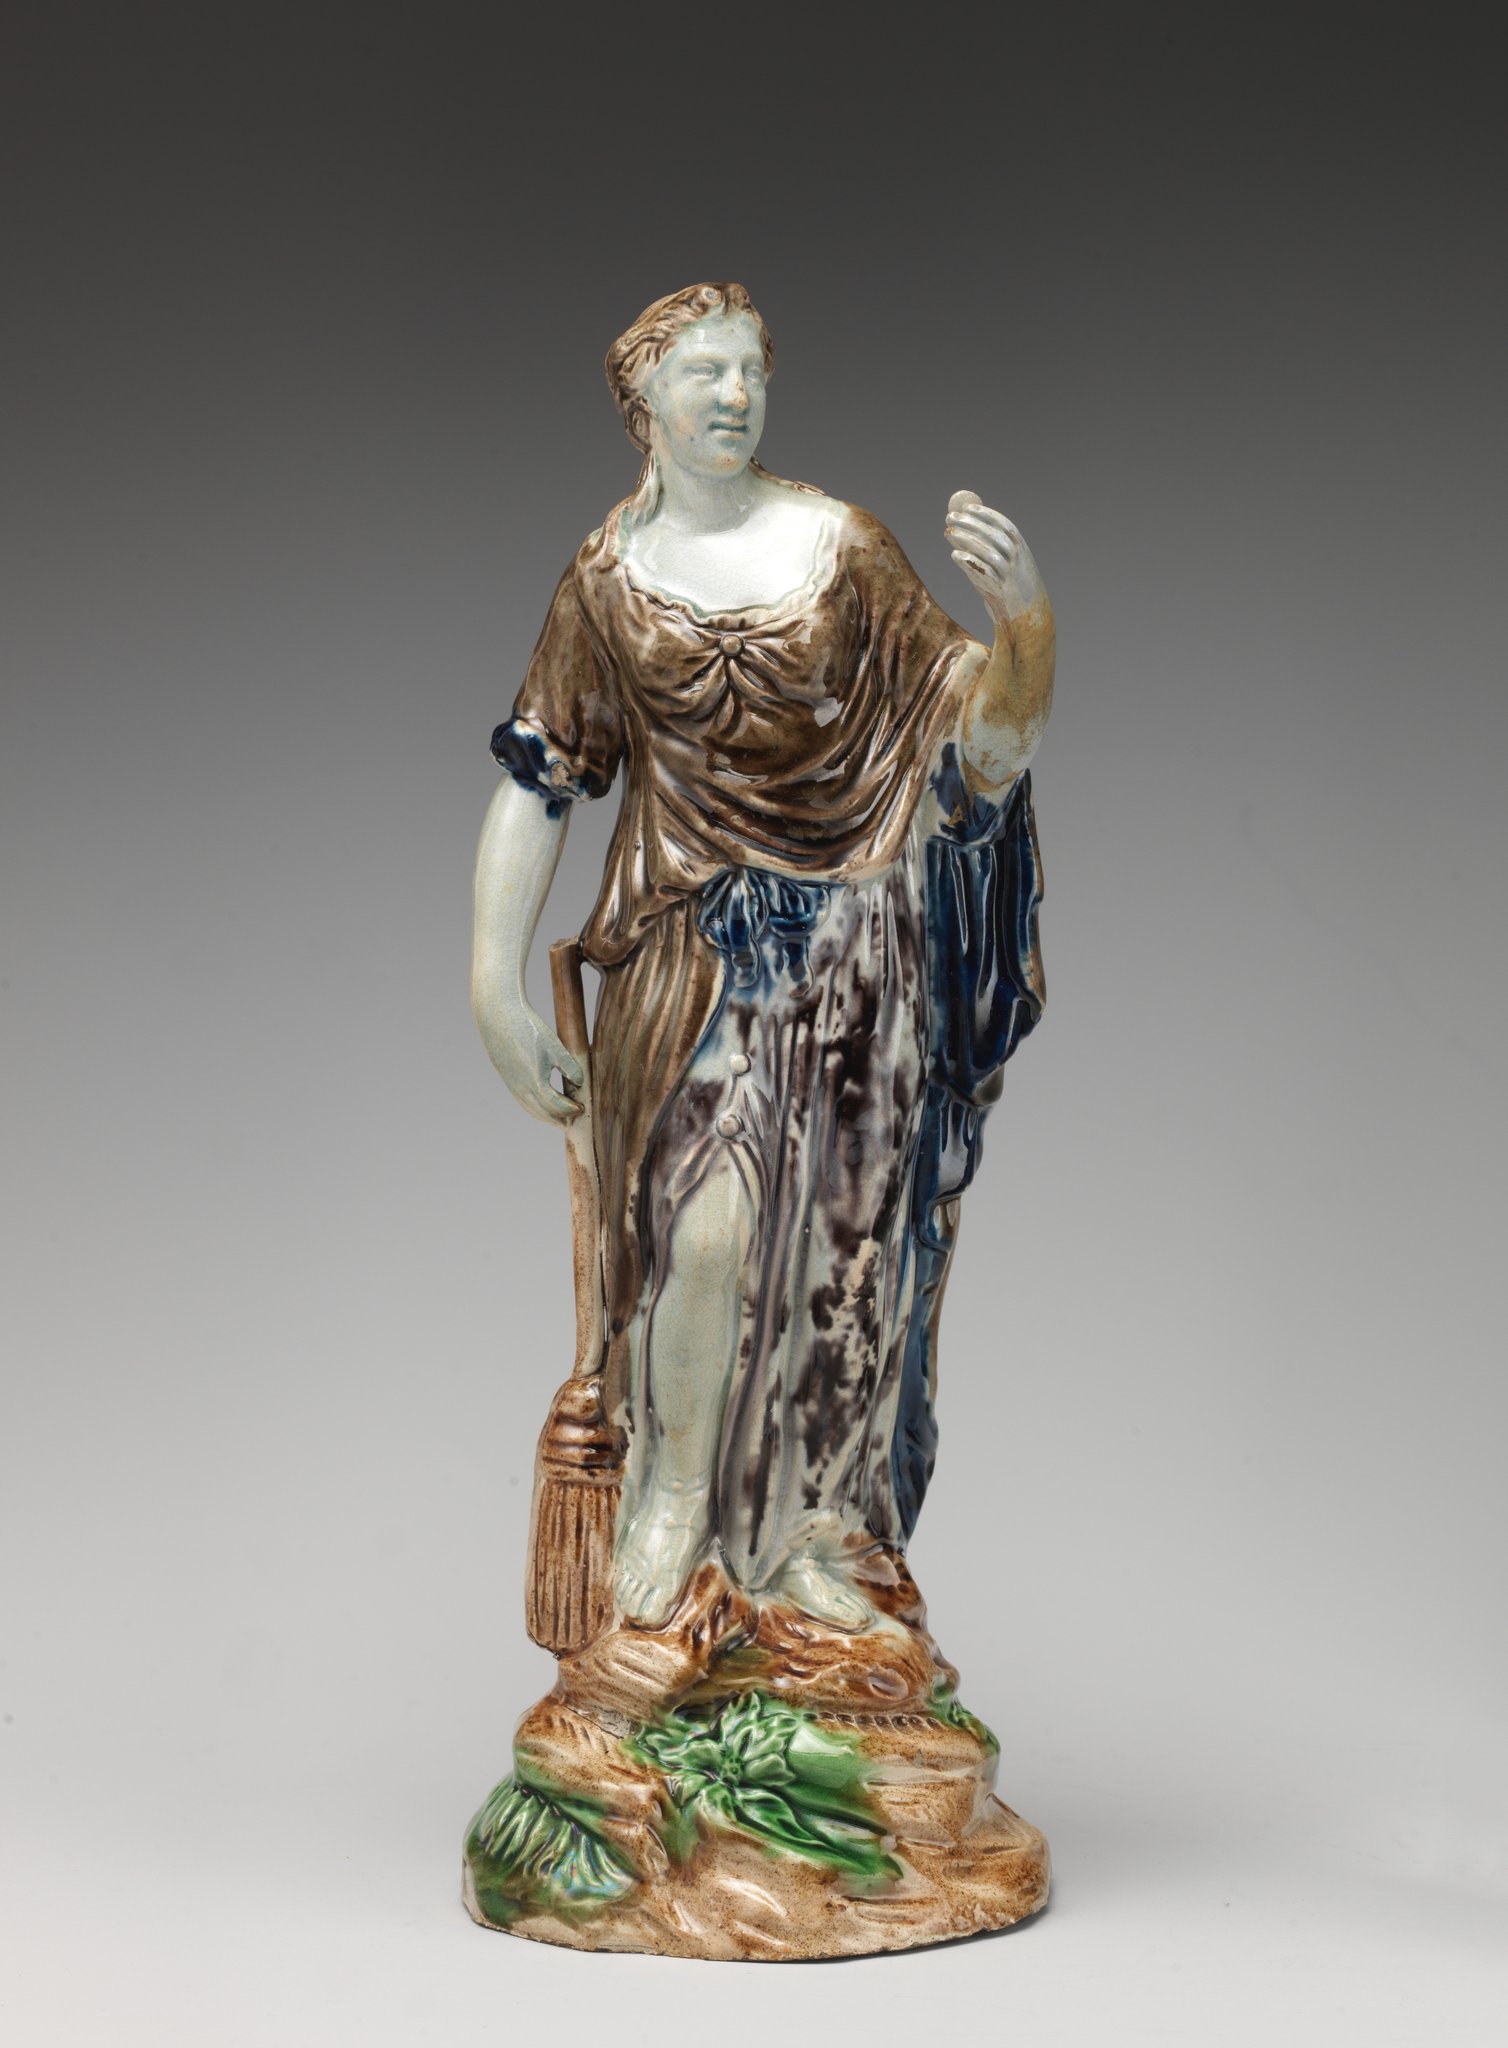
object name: figure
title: Woman with broom and coin ("The Parable of the Lost Piece of Silver")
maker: ralph wood the younger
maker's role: maker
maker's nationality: british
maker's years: 1748-1795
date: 1780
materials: earthenware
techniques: glazing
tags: women